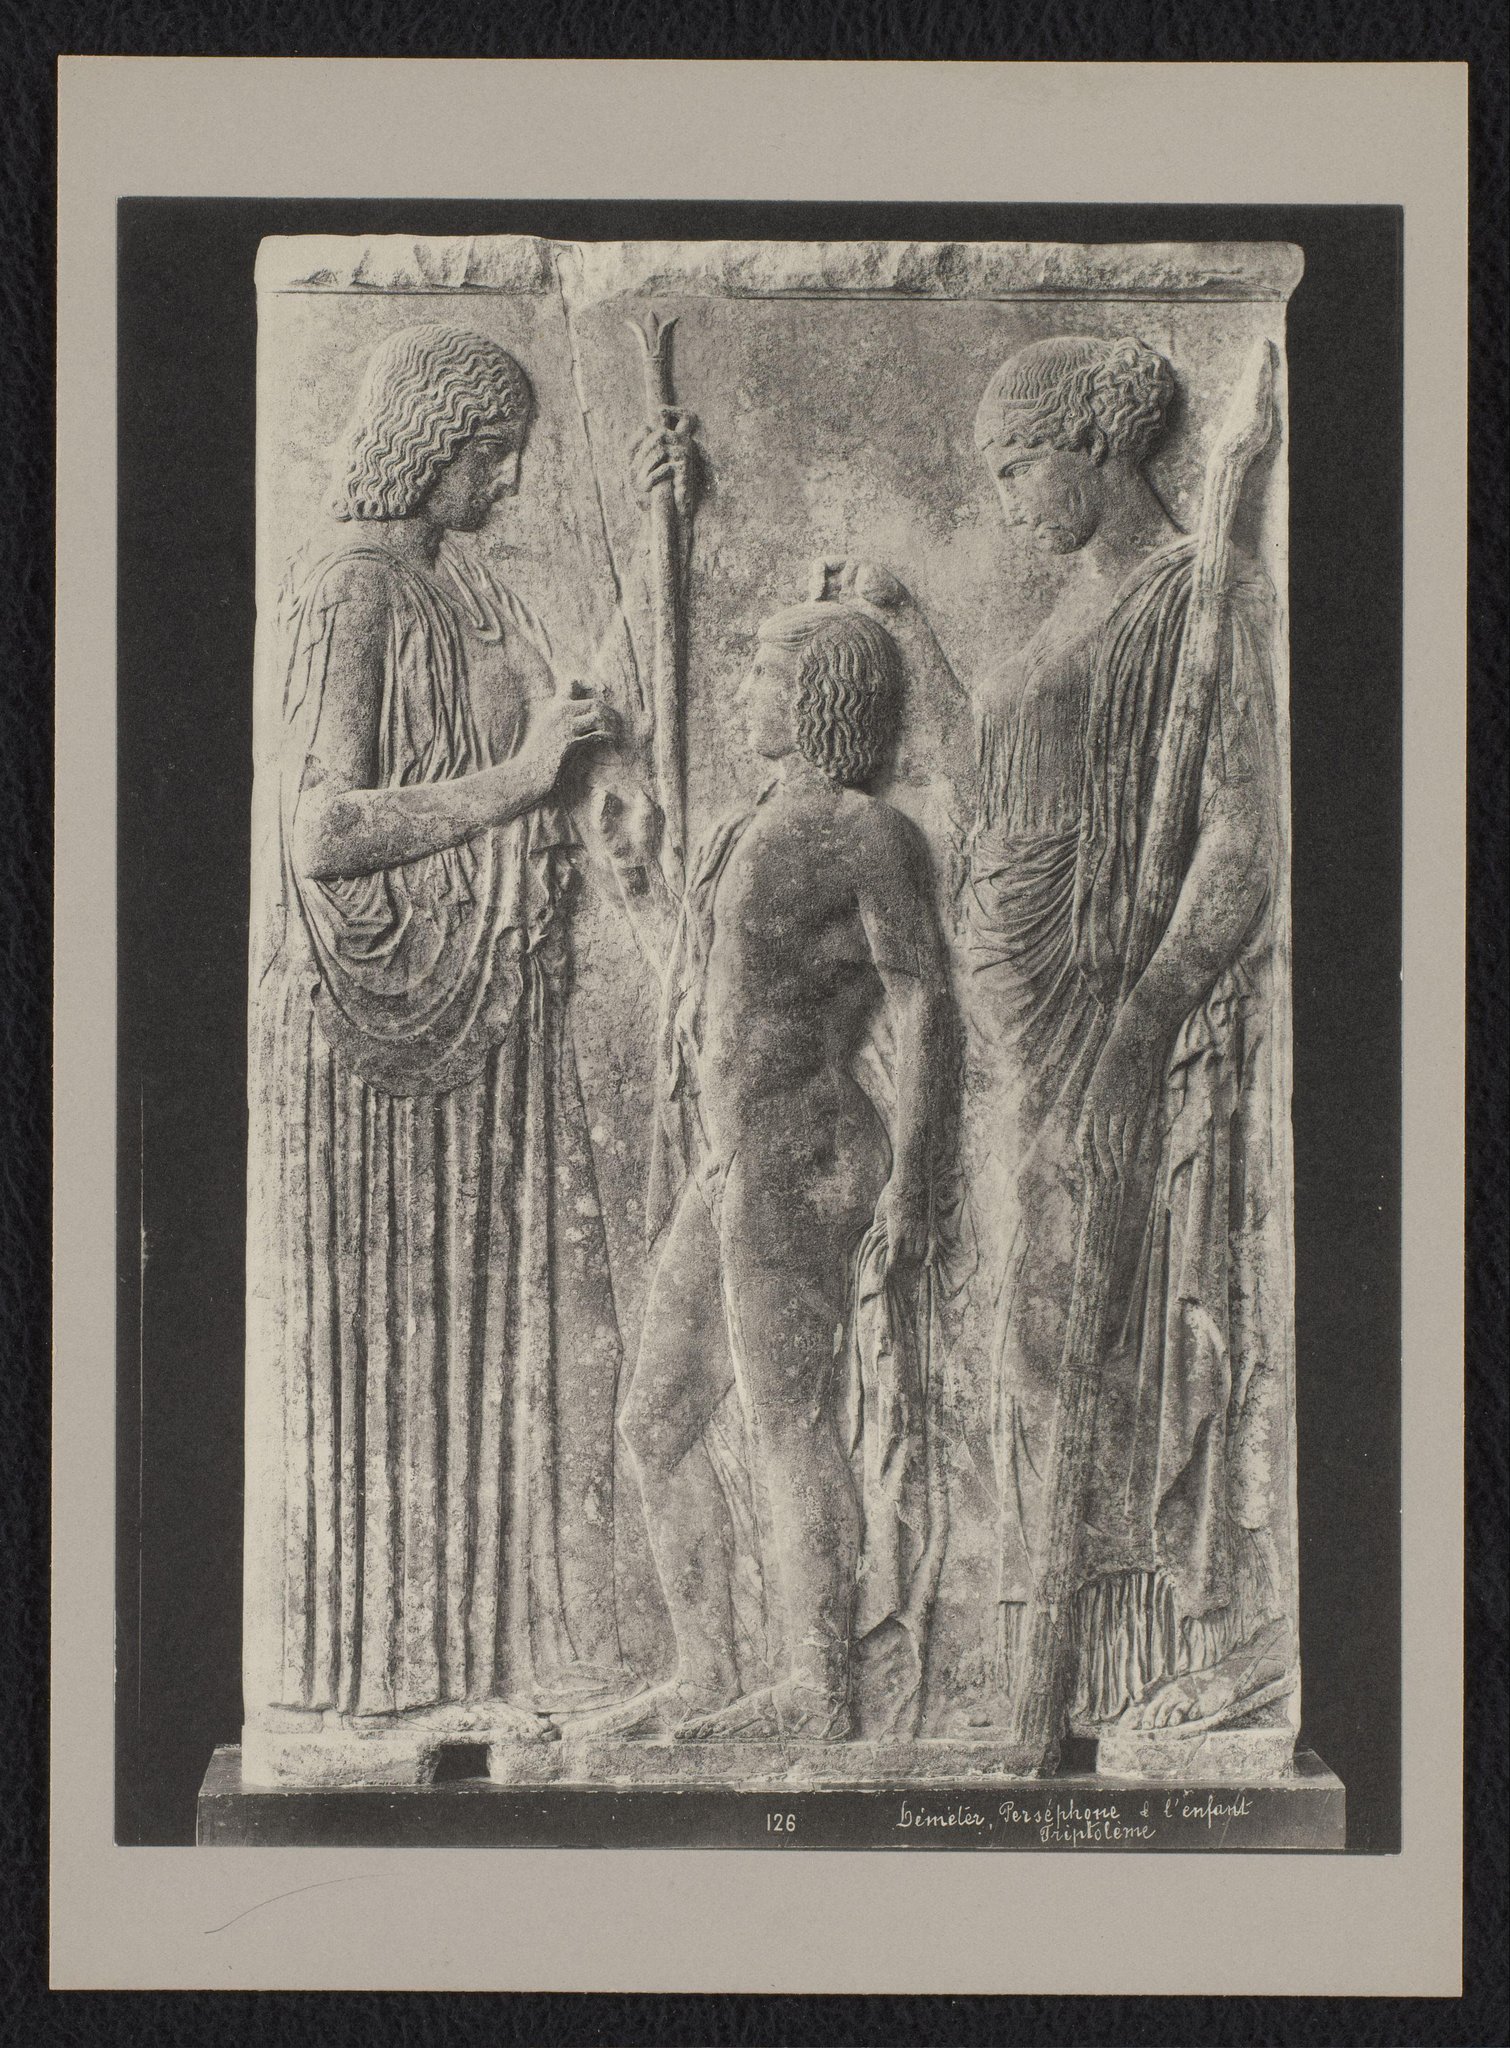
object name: photograph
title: Demeter, Persephone en het kind Triptolemos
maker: Anonymous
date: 1895-1915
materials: cardboard, paper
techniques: photograph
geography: greece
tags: griekenland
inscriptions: number: ‘45.’